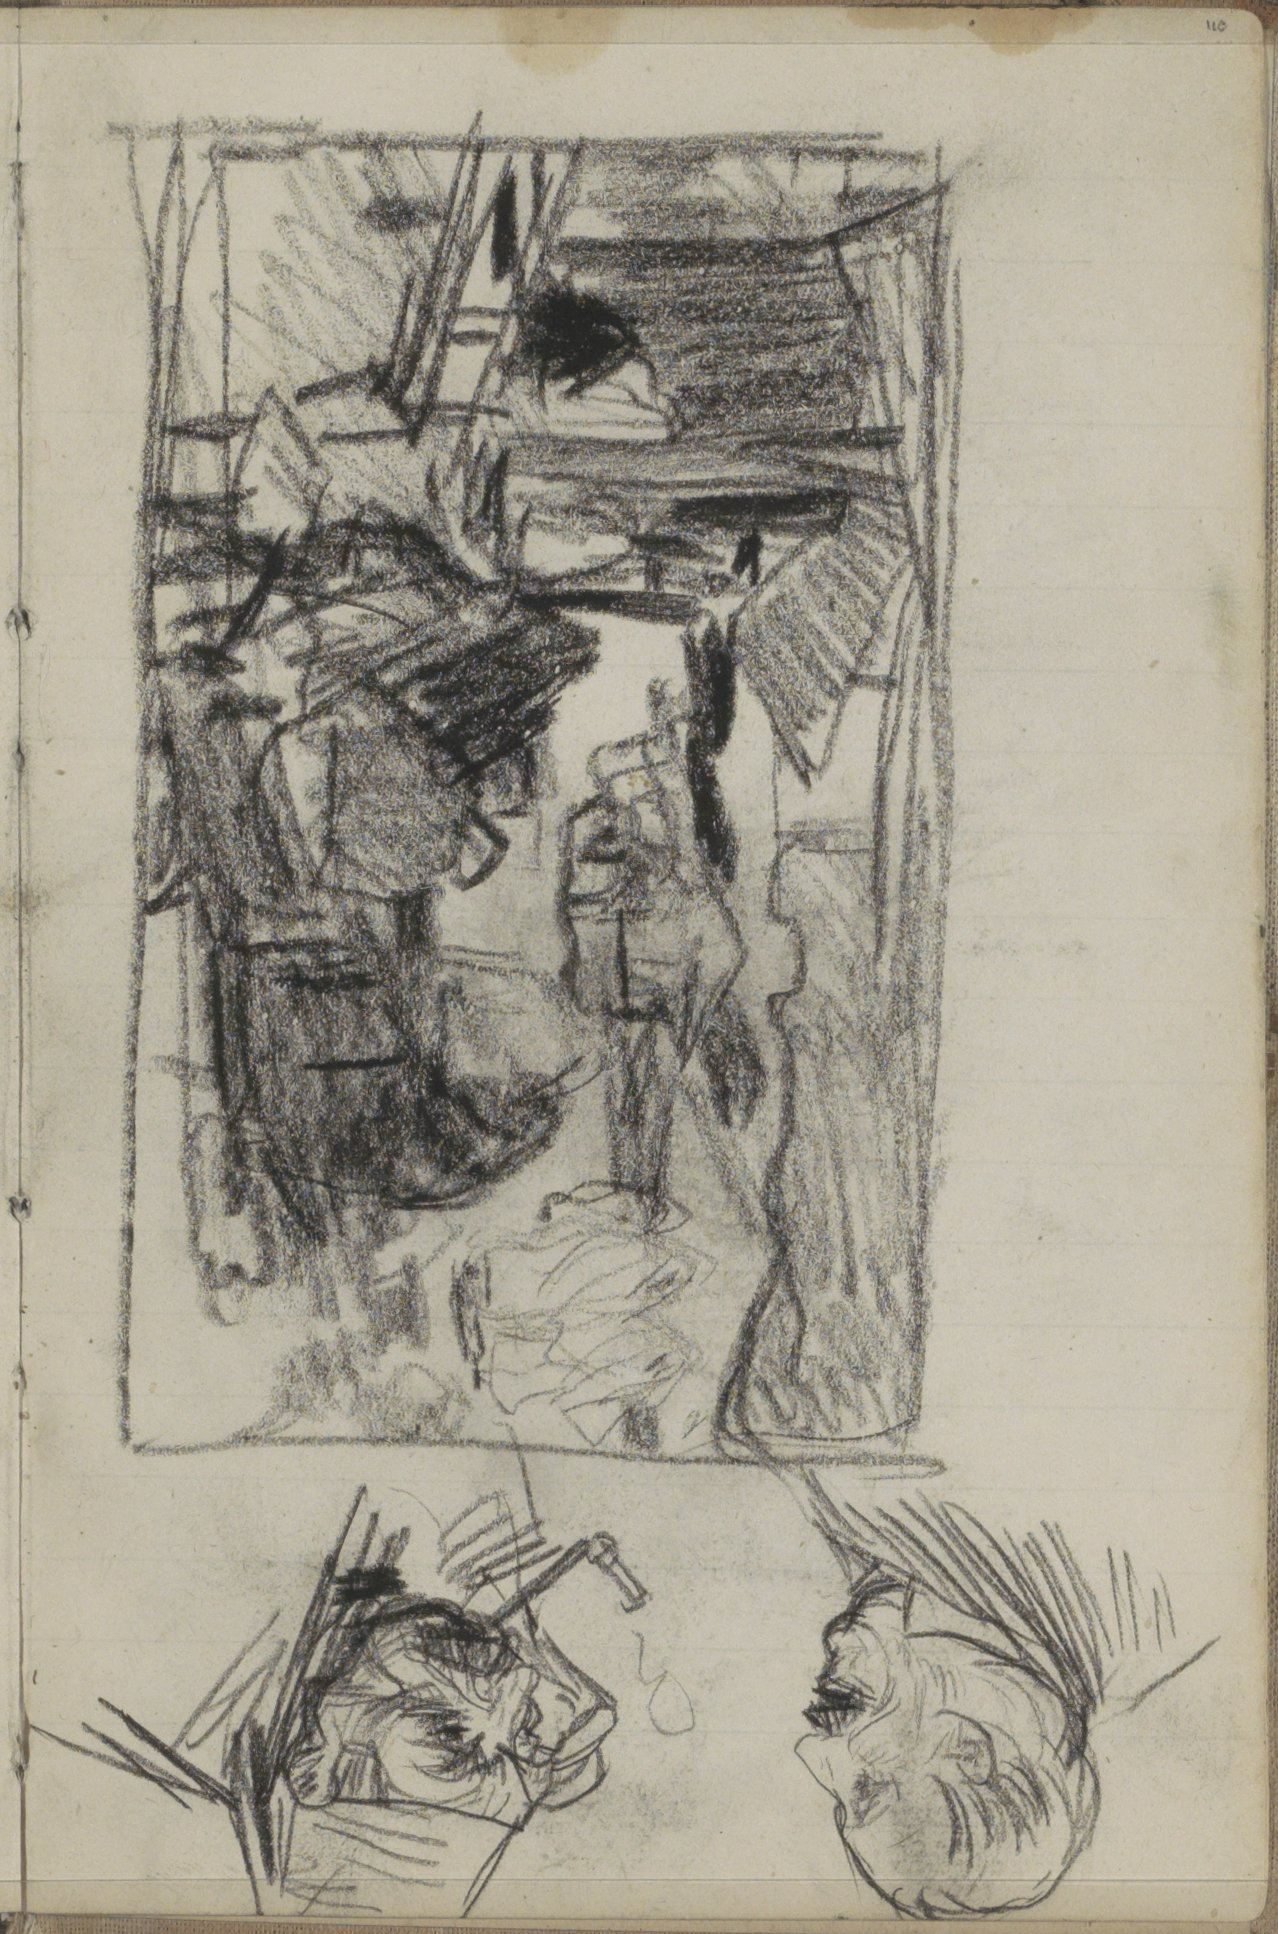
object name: sketchbook leaf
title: Studieblad, onder andere met een pijp rokende man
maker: marius bauer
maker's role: draughtsman, print maker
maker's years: 1867-1932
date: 1888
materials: chalk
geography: istanbul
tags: head (human), adult man, pipe ~ tobacco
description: Tevens een mannenkop en een studie. Pagina 110 uit een schetsboek met 58 bladen.